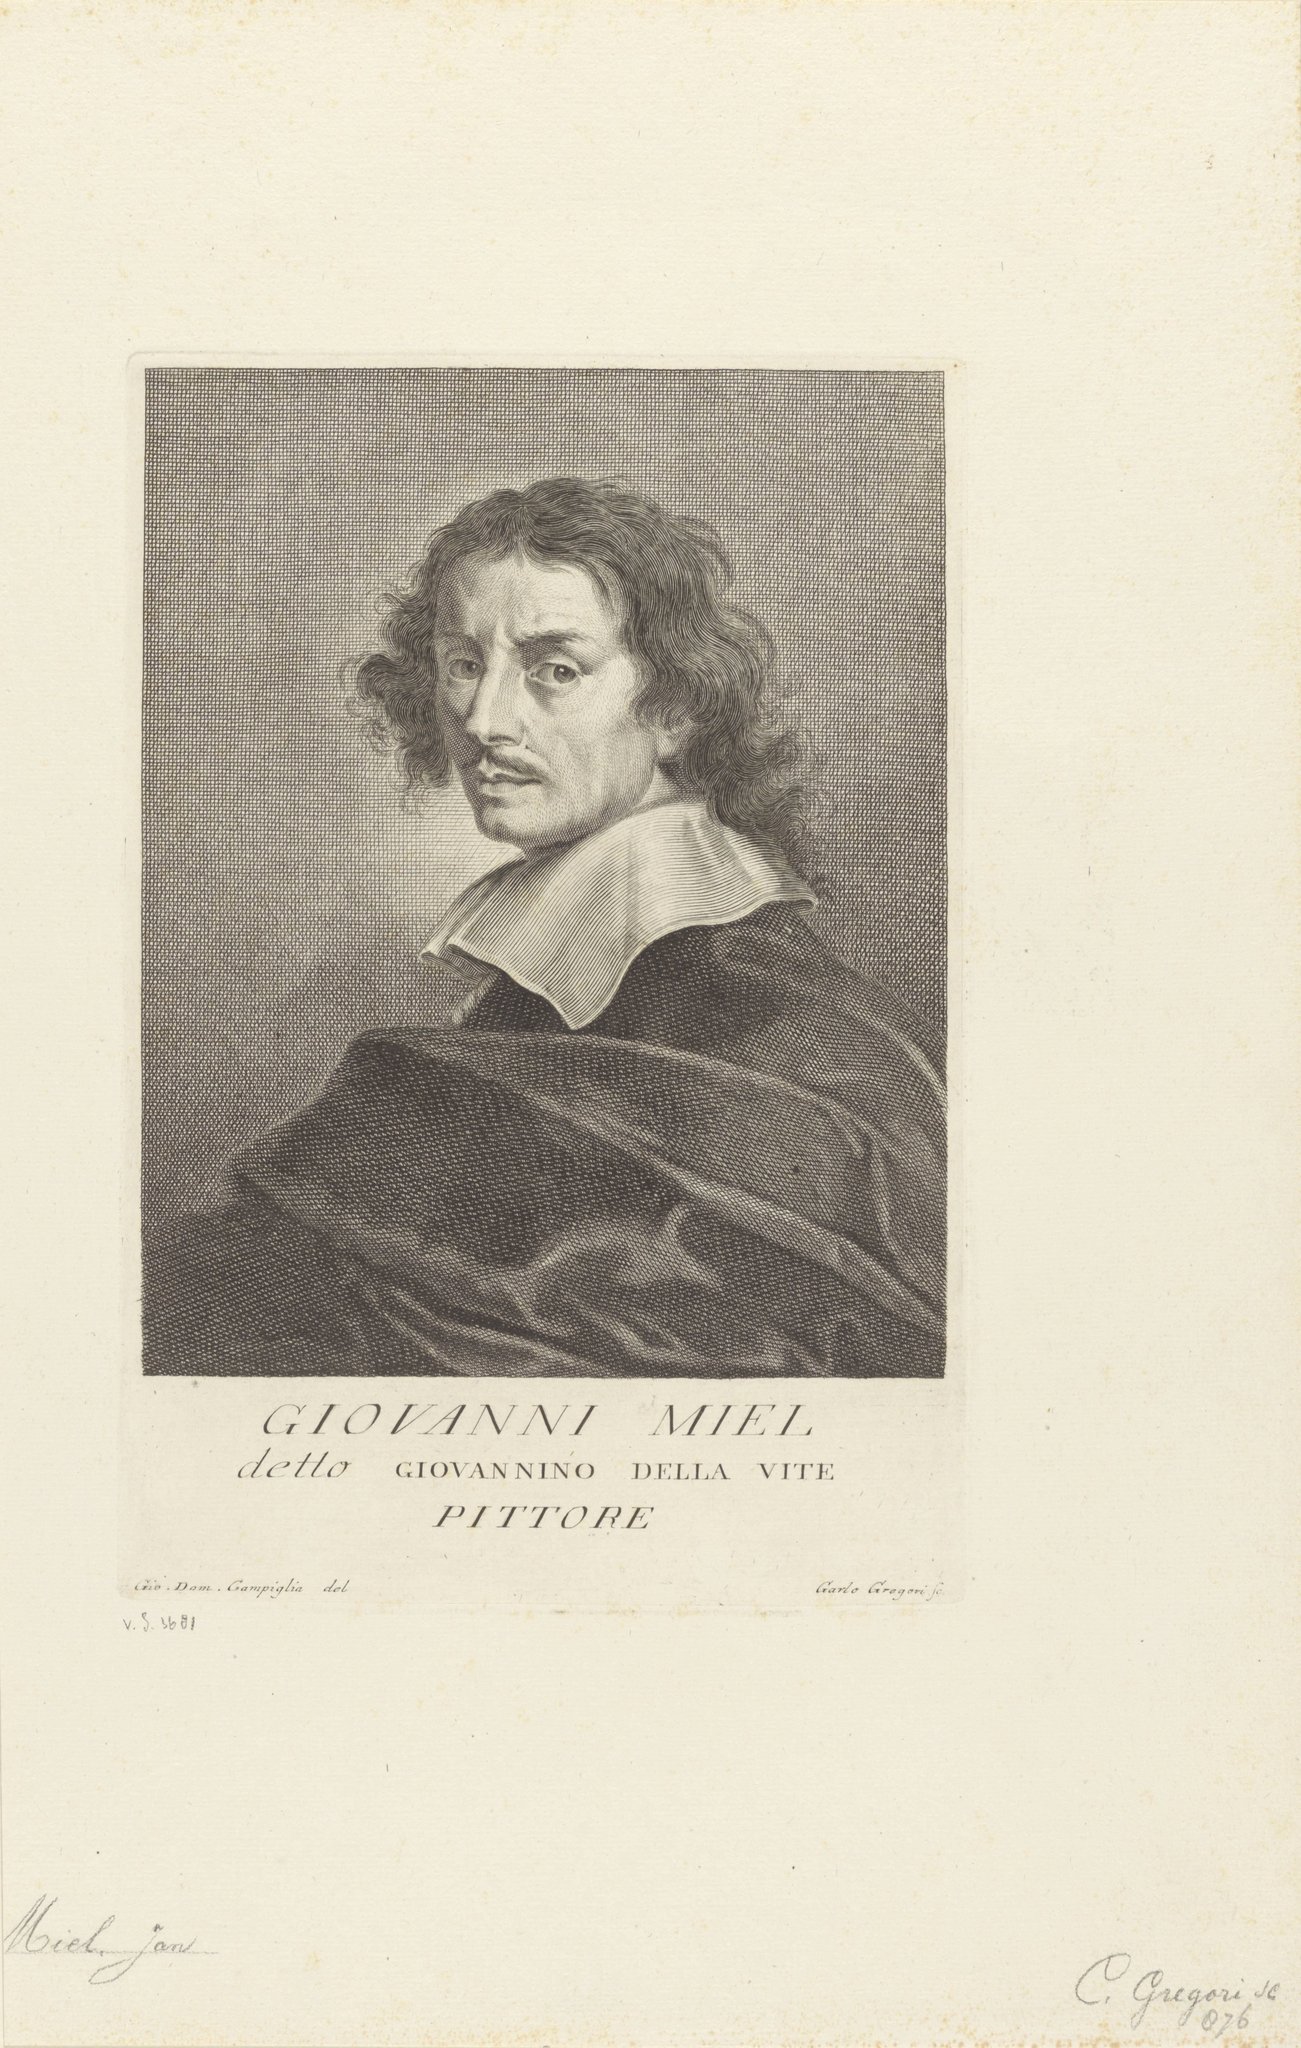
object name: print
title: Portretten van kunstenaars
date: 1752-1762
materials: paper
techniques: engraving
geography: italy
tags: jan miel, historical persons, portrait, self-portrait of artist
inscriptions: collector's mark: Lugt 2760, collector's mark: ‘RIJKS / MUSM’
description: Prent uit: Moücke, Francesco. Serie di ritratti degli eccellenti pittori dipinti di propria mano, che esistono nell'Imiperial Galleria di Firenze. Florence: 1752-1762, dl. III.